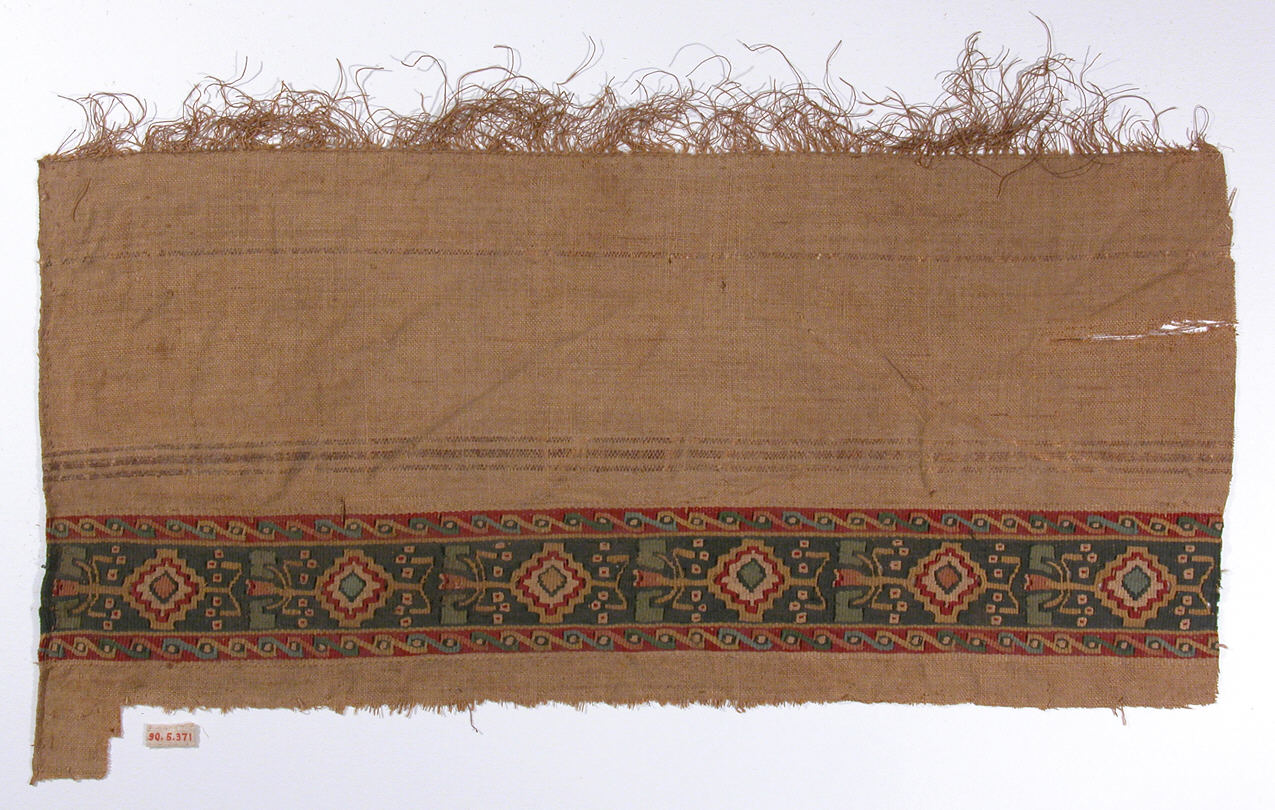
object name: textile fragment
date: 501-600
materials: linen, wool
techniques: weave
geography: egypt